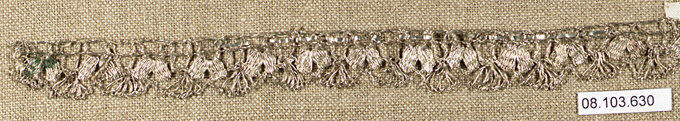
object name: piece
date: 1701-1800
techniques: lace